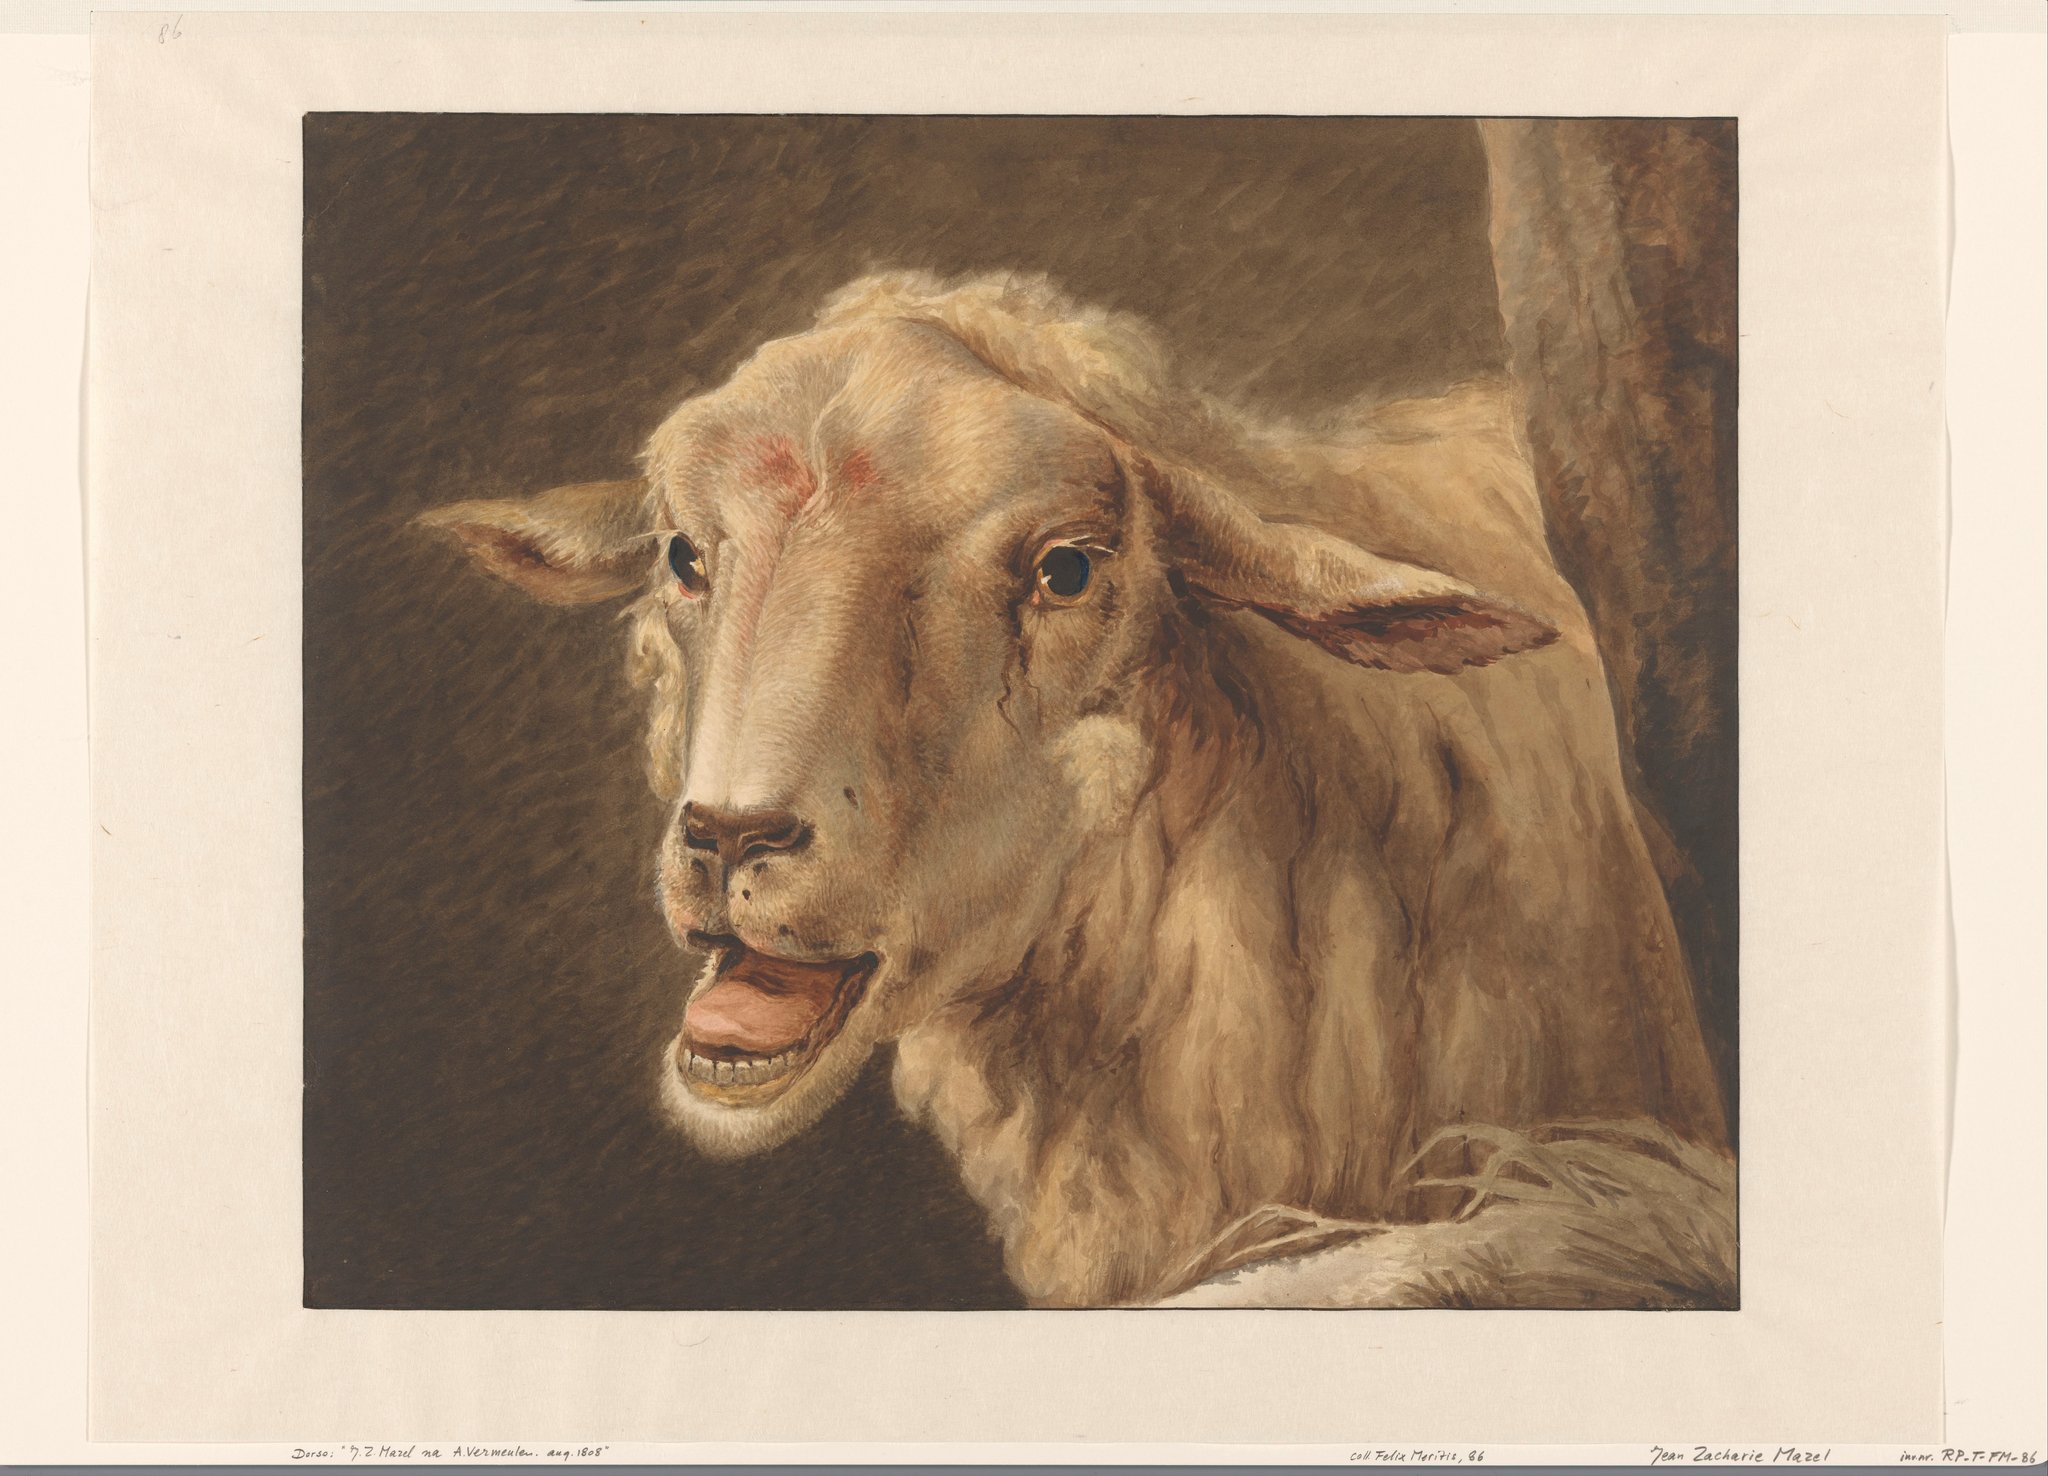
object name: drawing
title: Schaapskop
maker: jean zacherie mazel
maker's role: draughtsman, print maker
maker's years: 1792-1884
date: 1808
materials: paper, pencil, watercolor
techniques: brush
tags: sheep